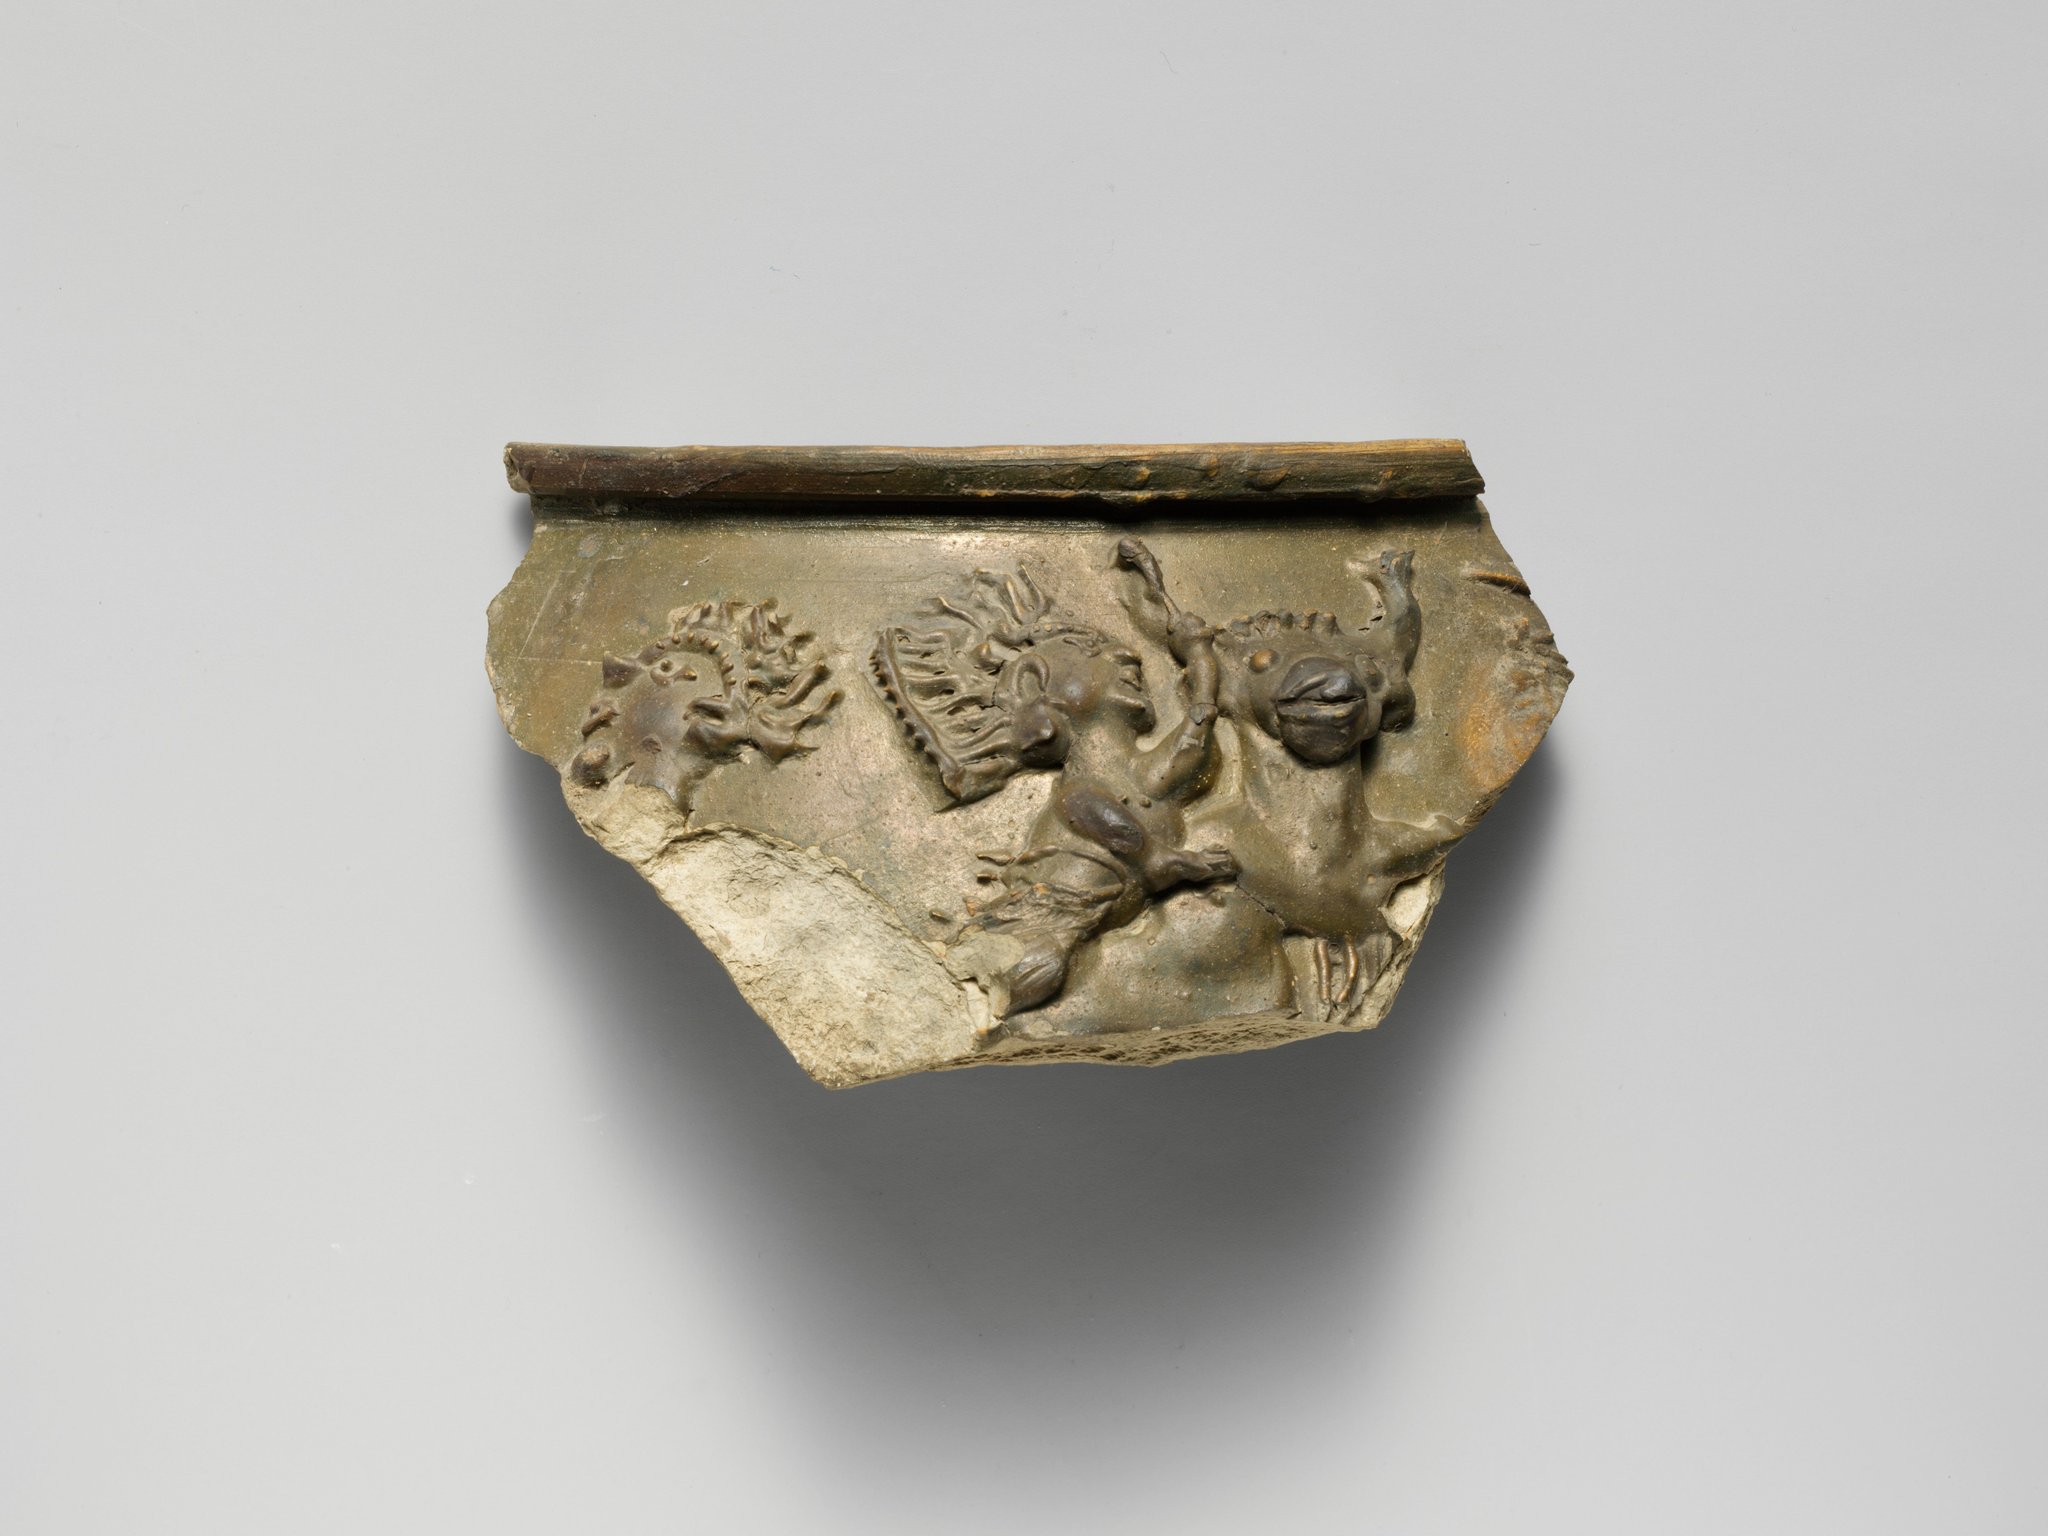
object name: vase fragment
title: Terracotta fragment from the rim of a vase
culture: roman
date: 251-300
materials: terracotta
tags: zeus,europa